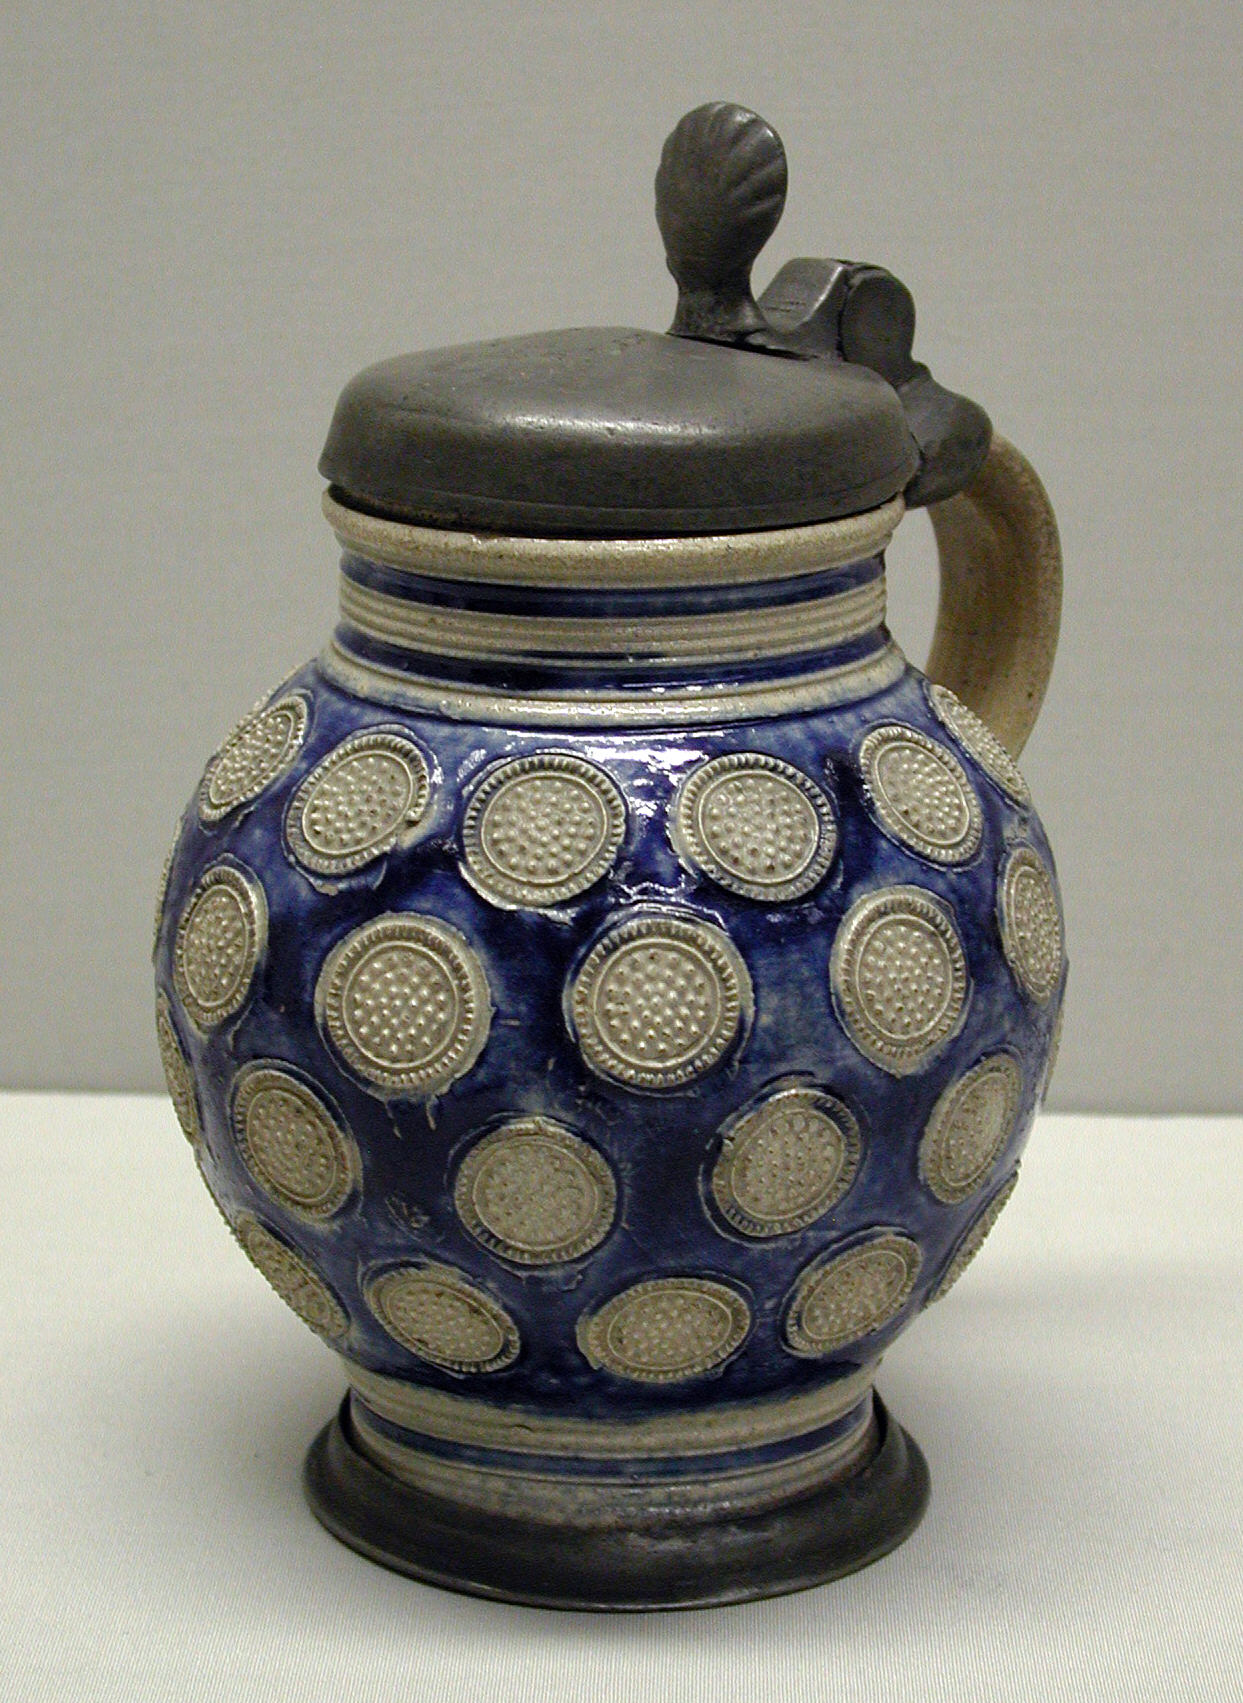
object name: tankard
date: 1601-1633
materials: pewter, stoneware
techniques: salt glaze